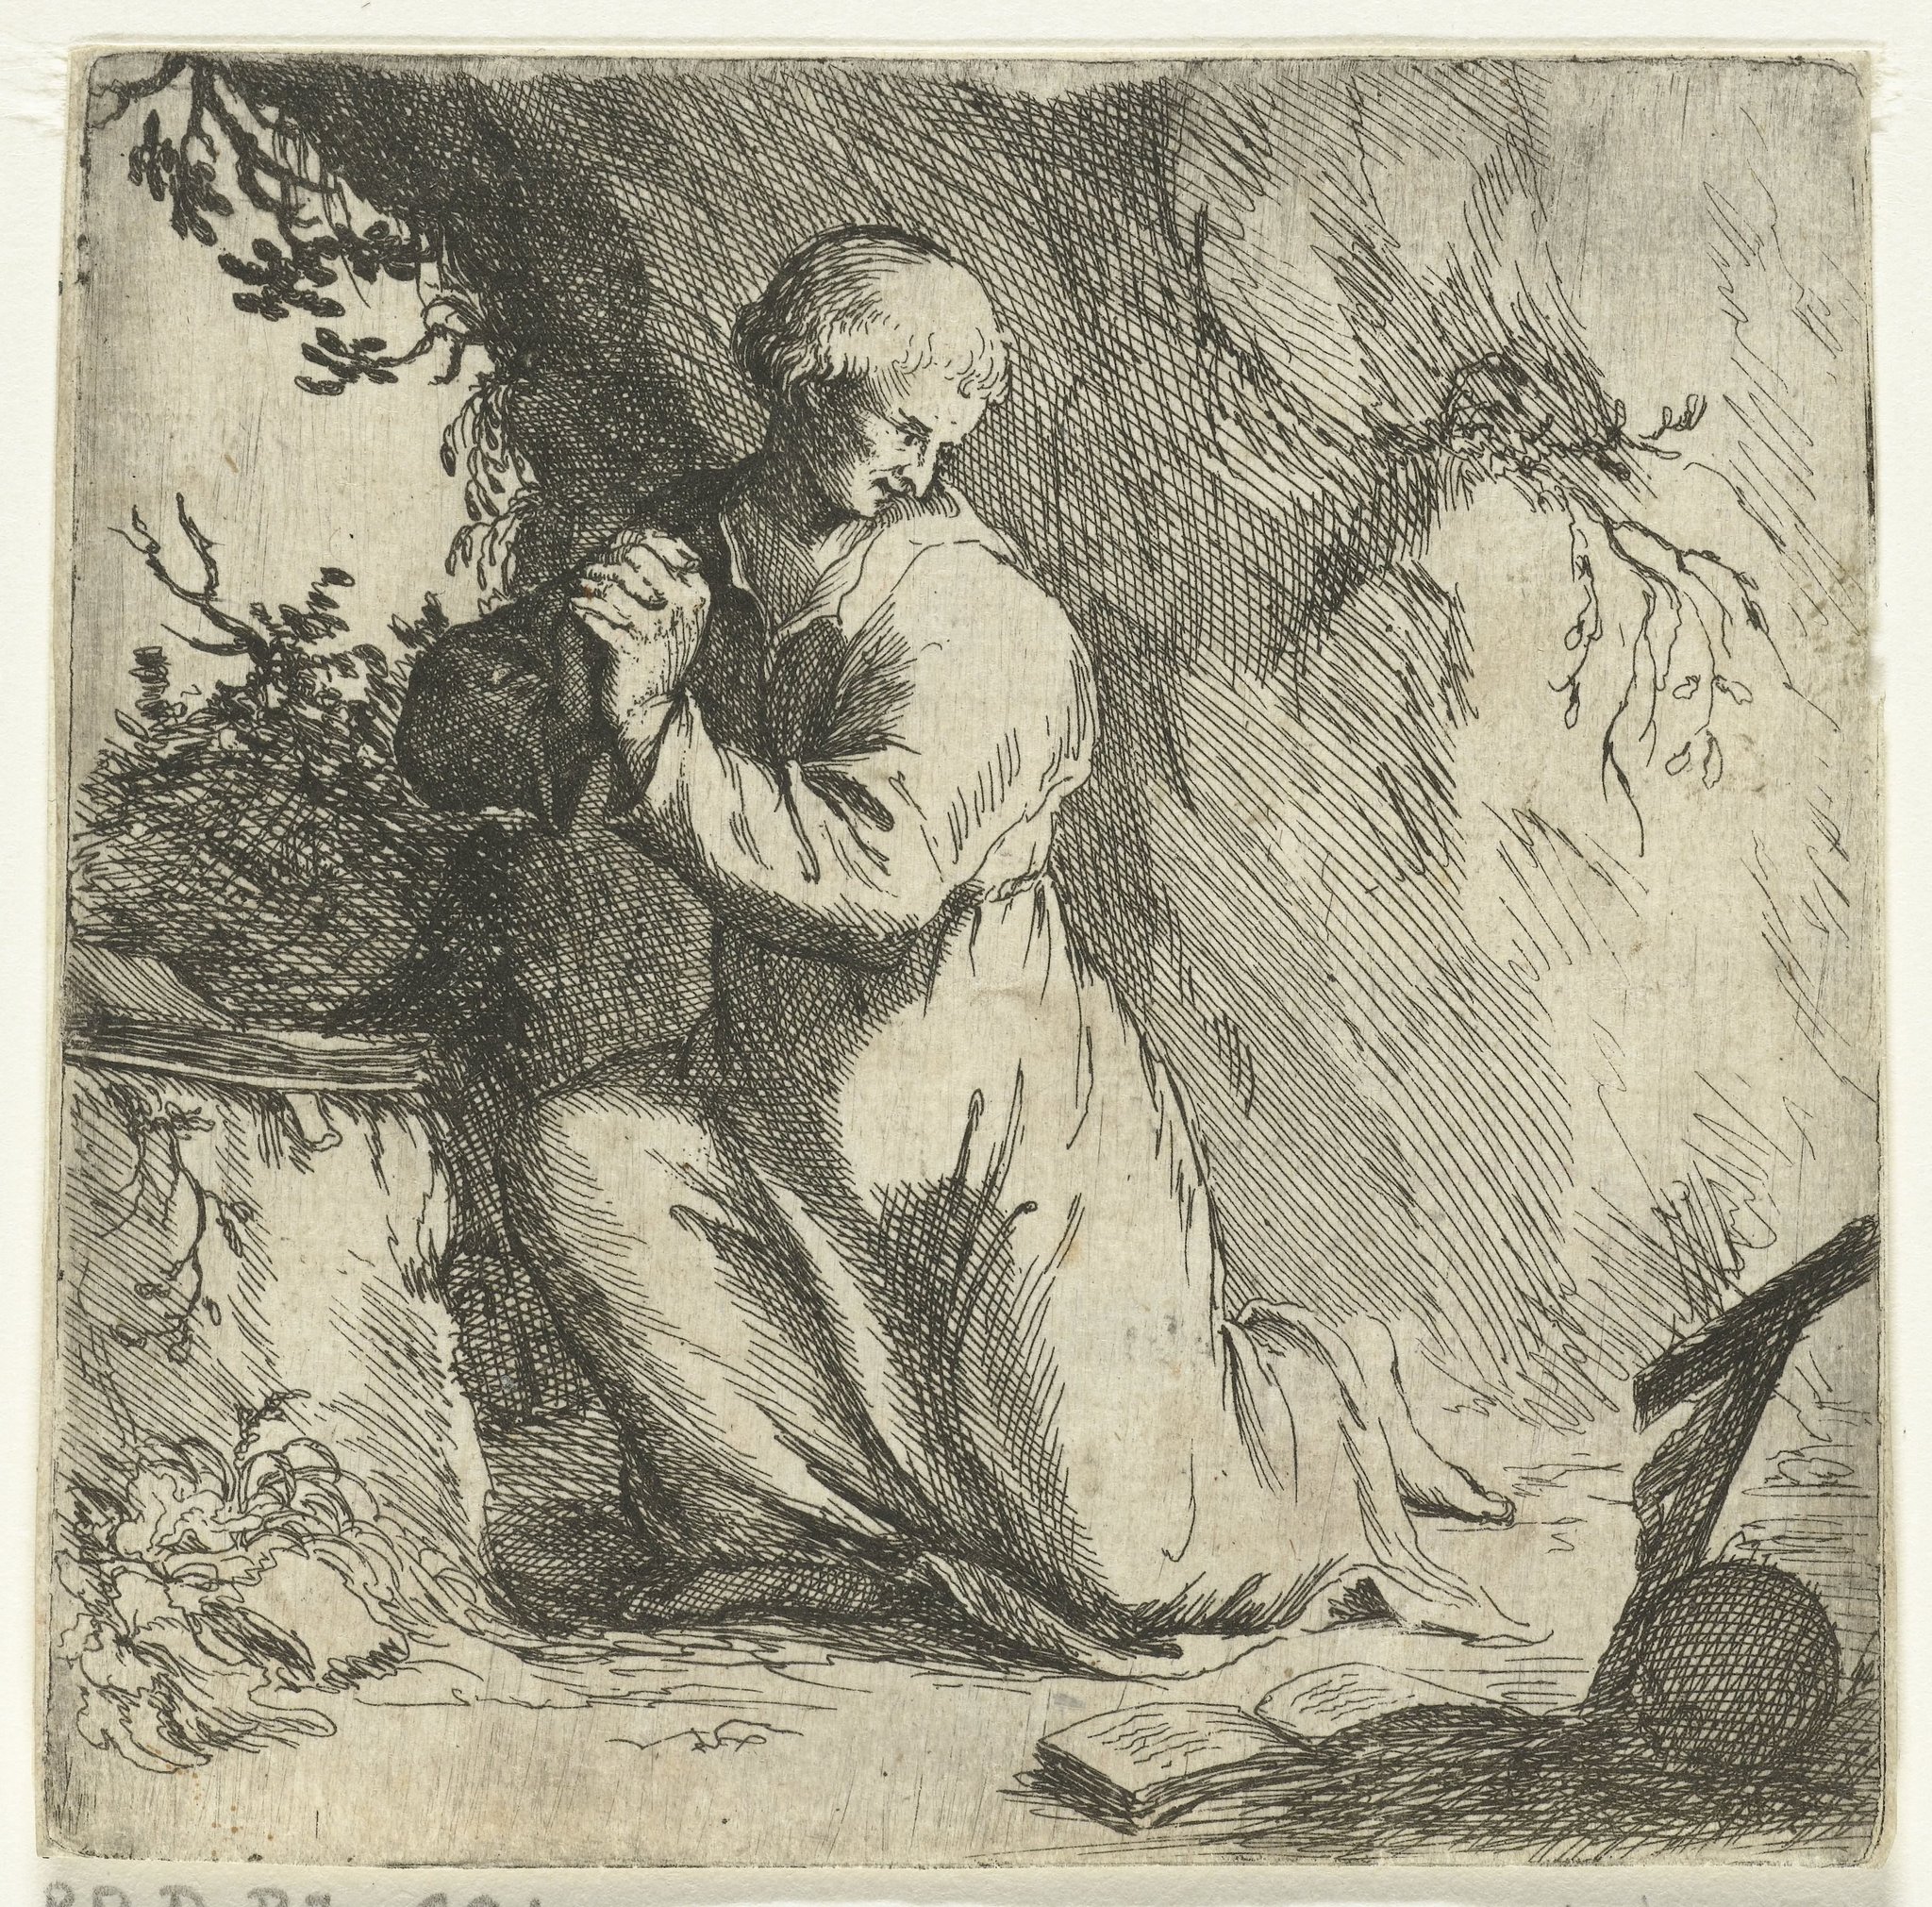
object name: print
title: Biddende kluizenaar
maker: willem basse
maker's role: draughtsman, print maker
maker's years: 1613-1672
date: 1633-1672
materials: paper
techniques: etching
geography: amsterdam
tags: hands folded with fingers knit, anchorite, hermit, one person praying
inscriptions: collector's mark: Lugt 240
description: Een kluizenaar knielt in een grot. Hij kijkt naar een kruis dat op de grond ligt en bidt.